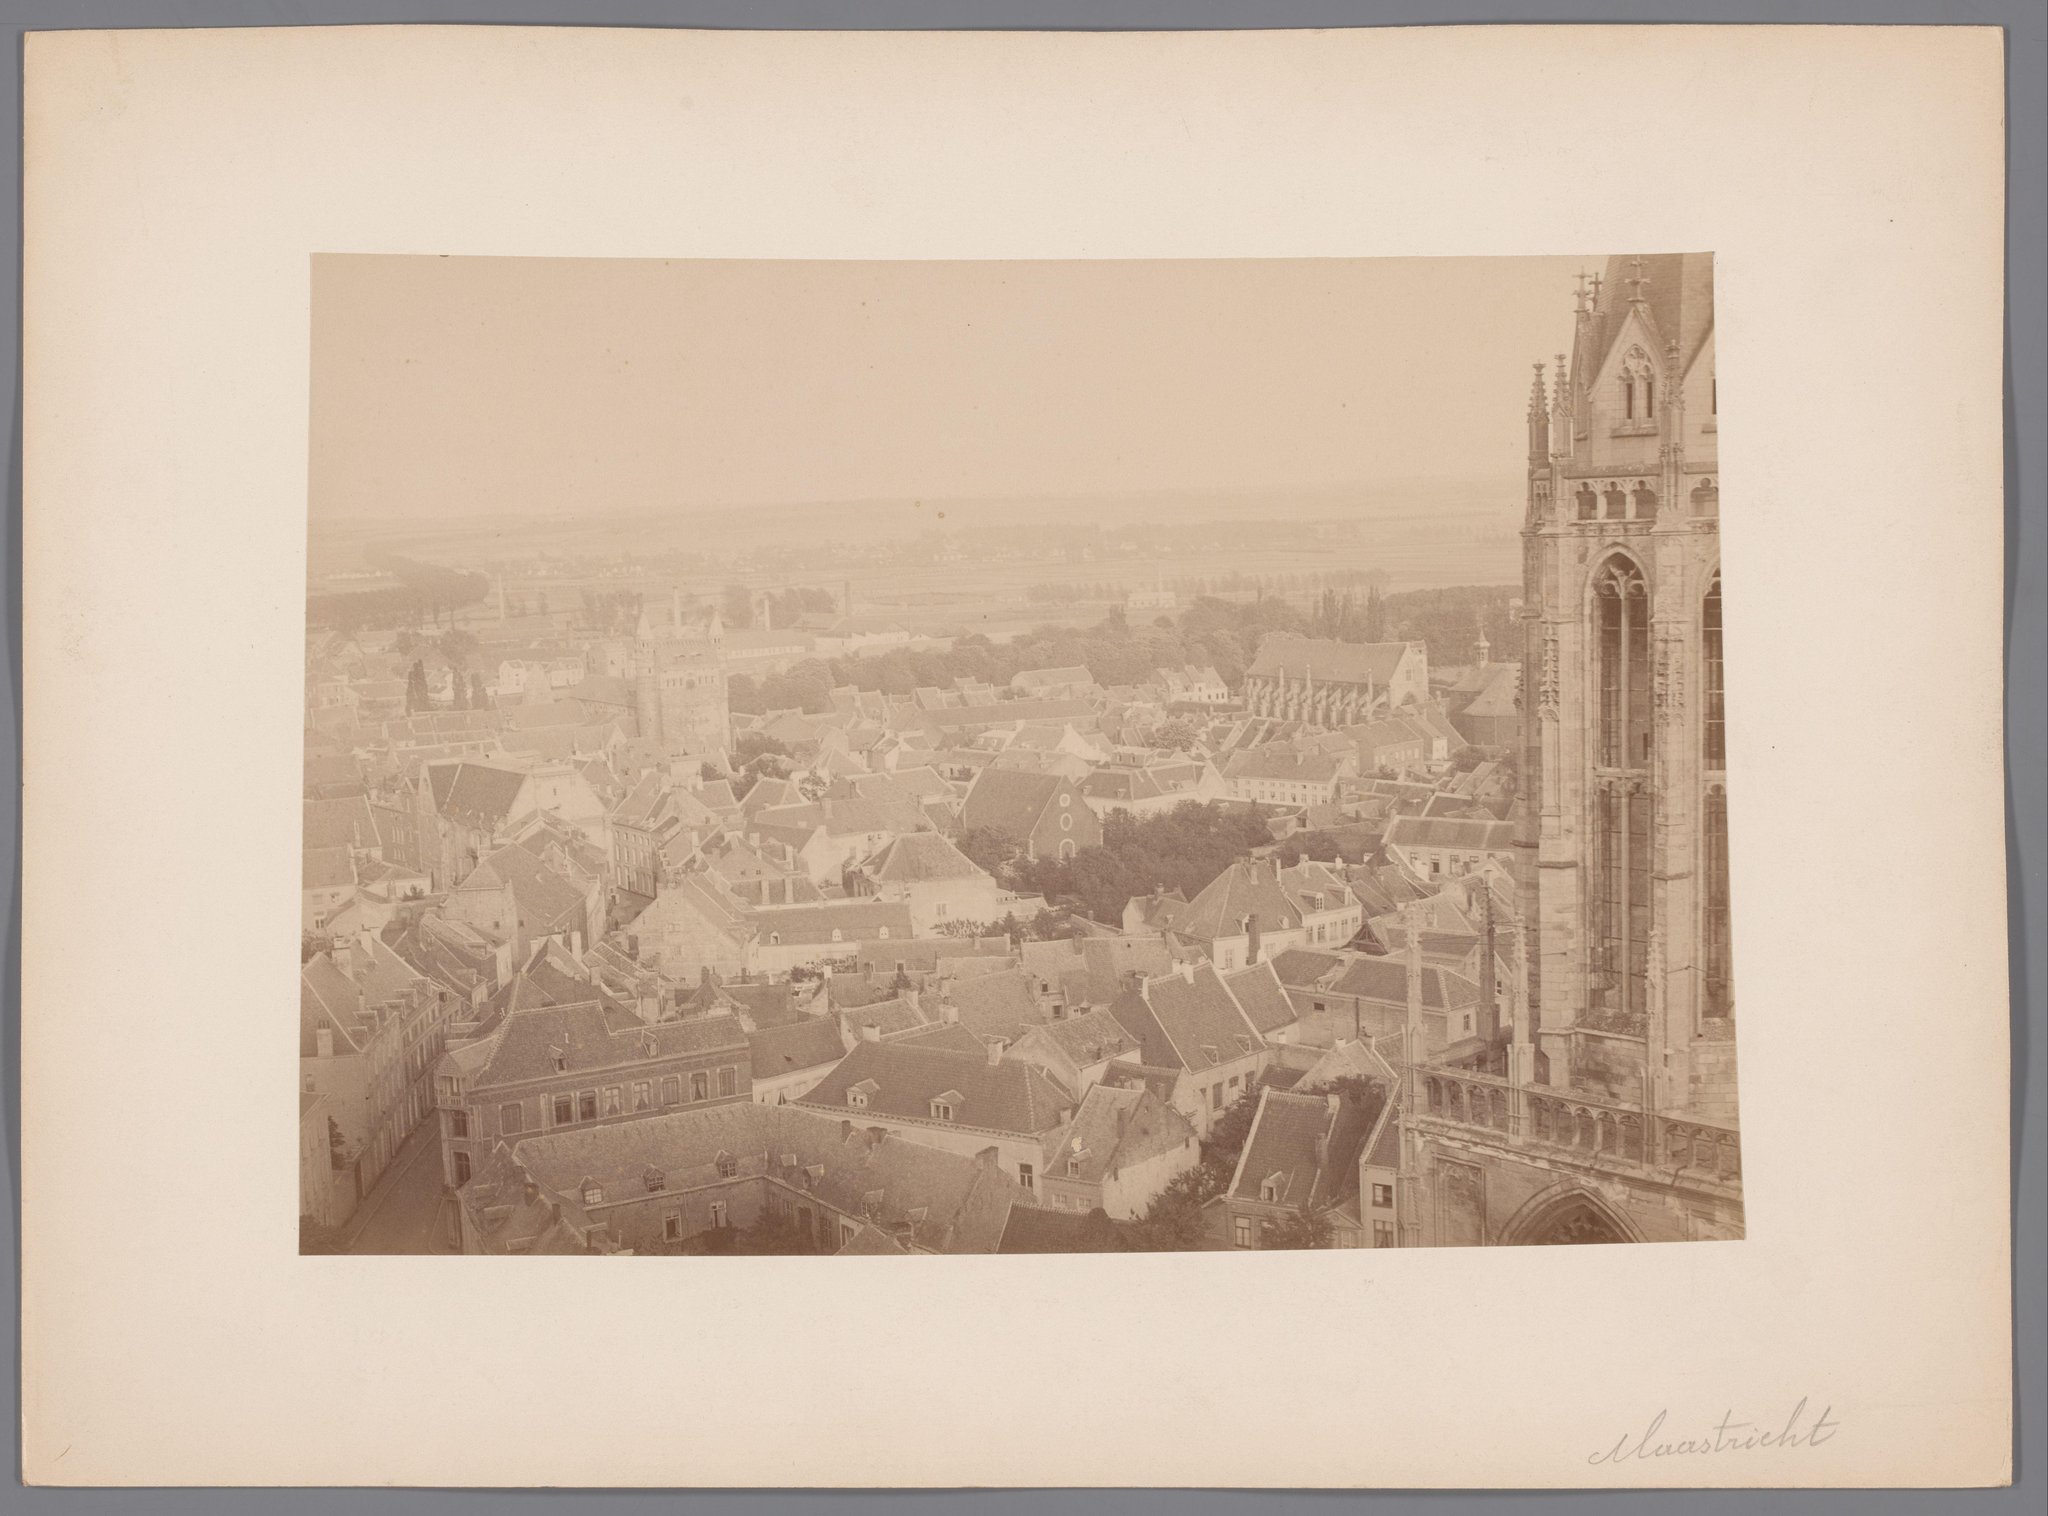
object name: photograph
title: Gezicht op Maastricht met de toren van de Sint-Janskerk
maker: anoniem (monumentenzorg)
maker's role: fotograaf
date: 1893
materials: cardboard, photographic support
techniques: albumen print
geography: maastricht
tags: city-view in general; 'veduta', parts of church exterior and annexes: tower, maastricht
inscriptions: annotation: ‘Maastricht/ Panorama van op den St. Servaastoren/ Mei 1893’, annotation: ‘Maastricht’